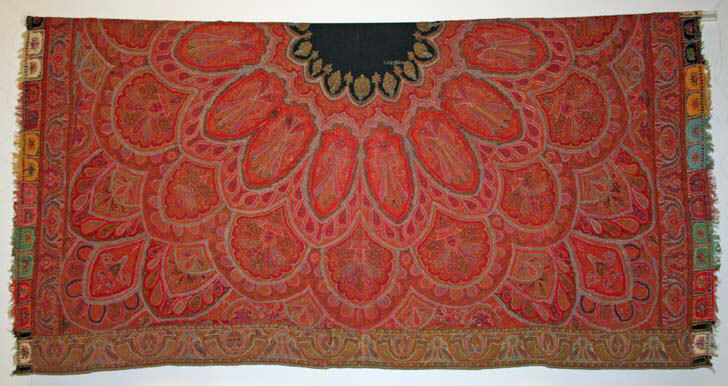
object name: shawl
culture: indian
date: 1850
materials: wool